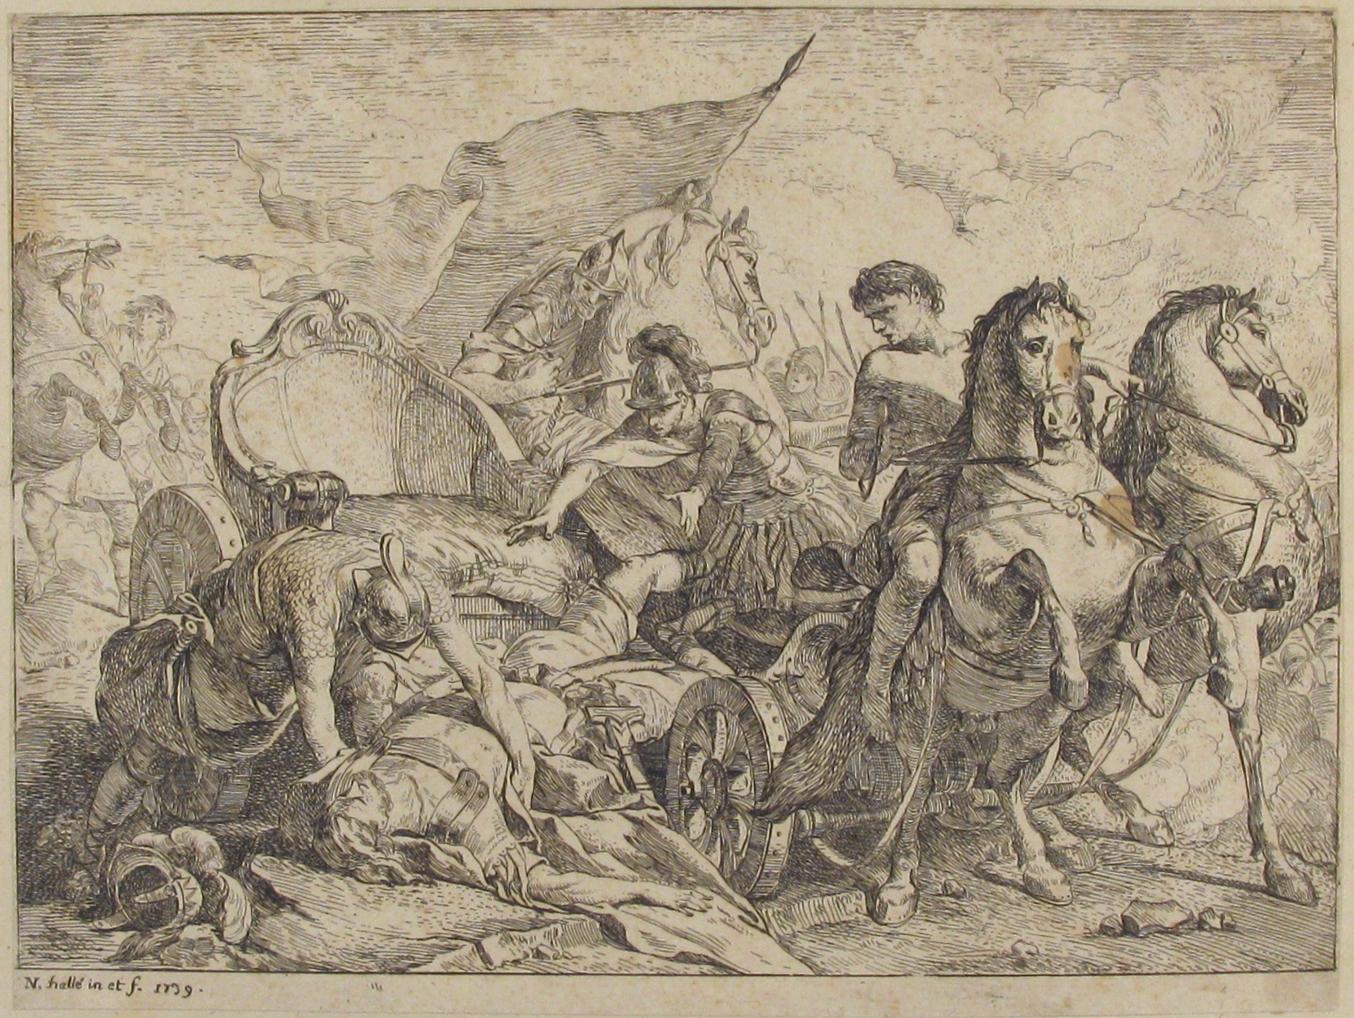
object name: print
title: Fall of Antiochus From His Chariot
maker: noël hallé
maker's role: artist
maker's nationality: french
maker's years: 1711-1781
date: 1739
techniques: etching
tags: soldiers,men,horses,chariots